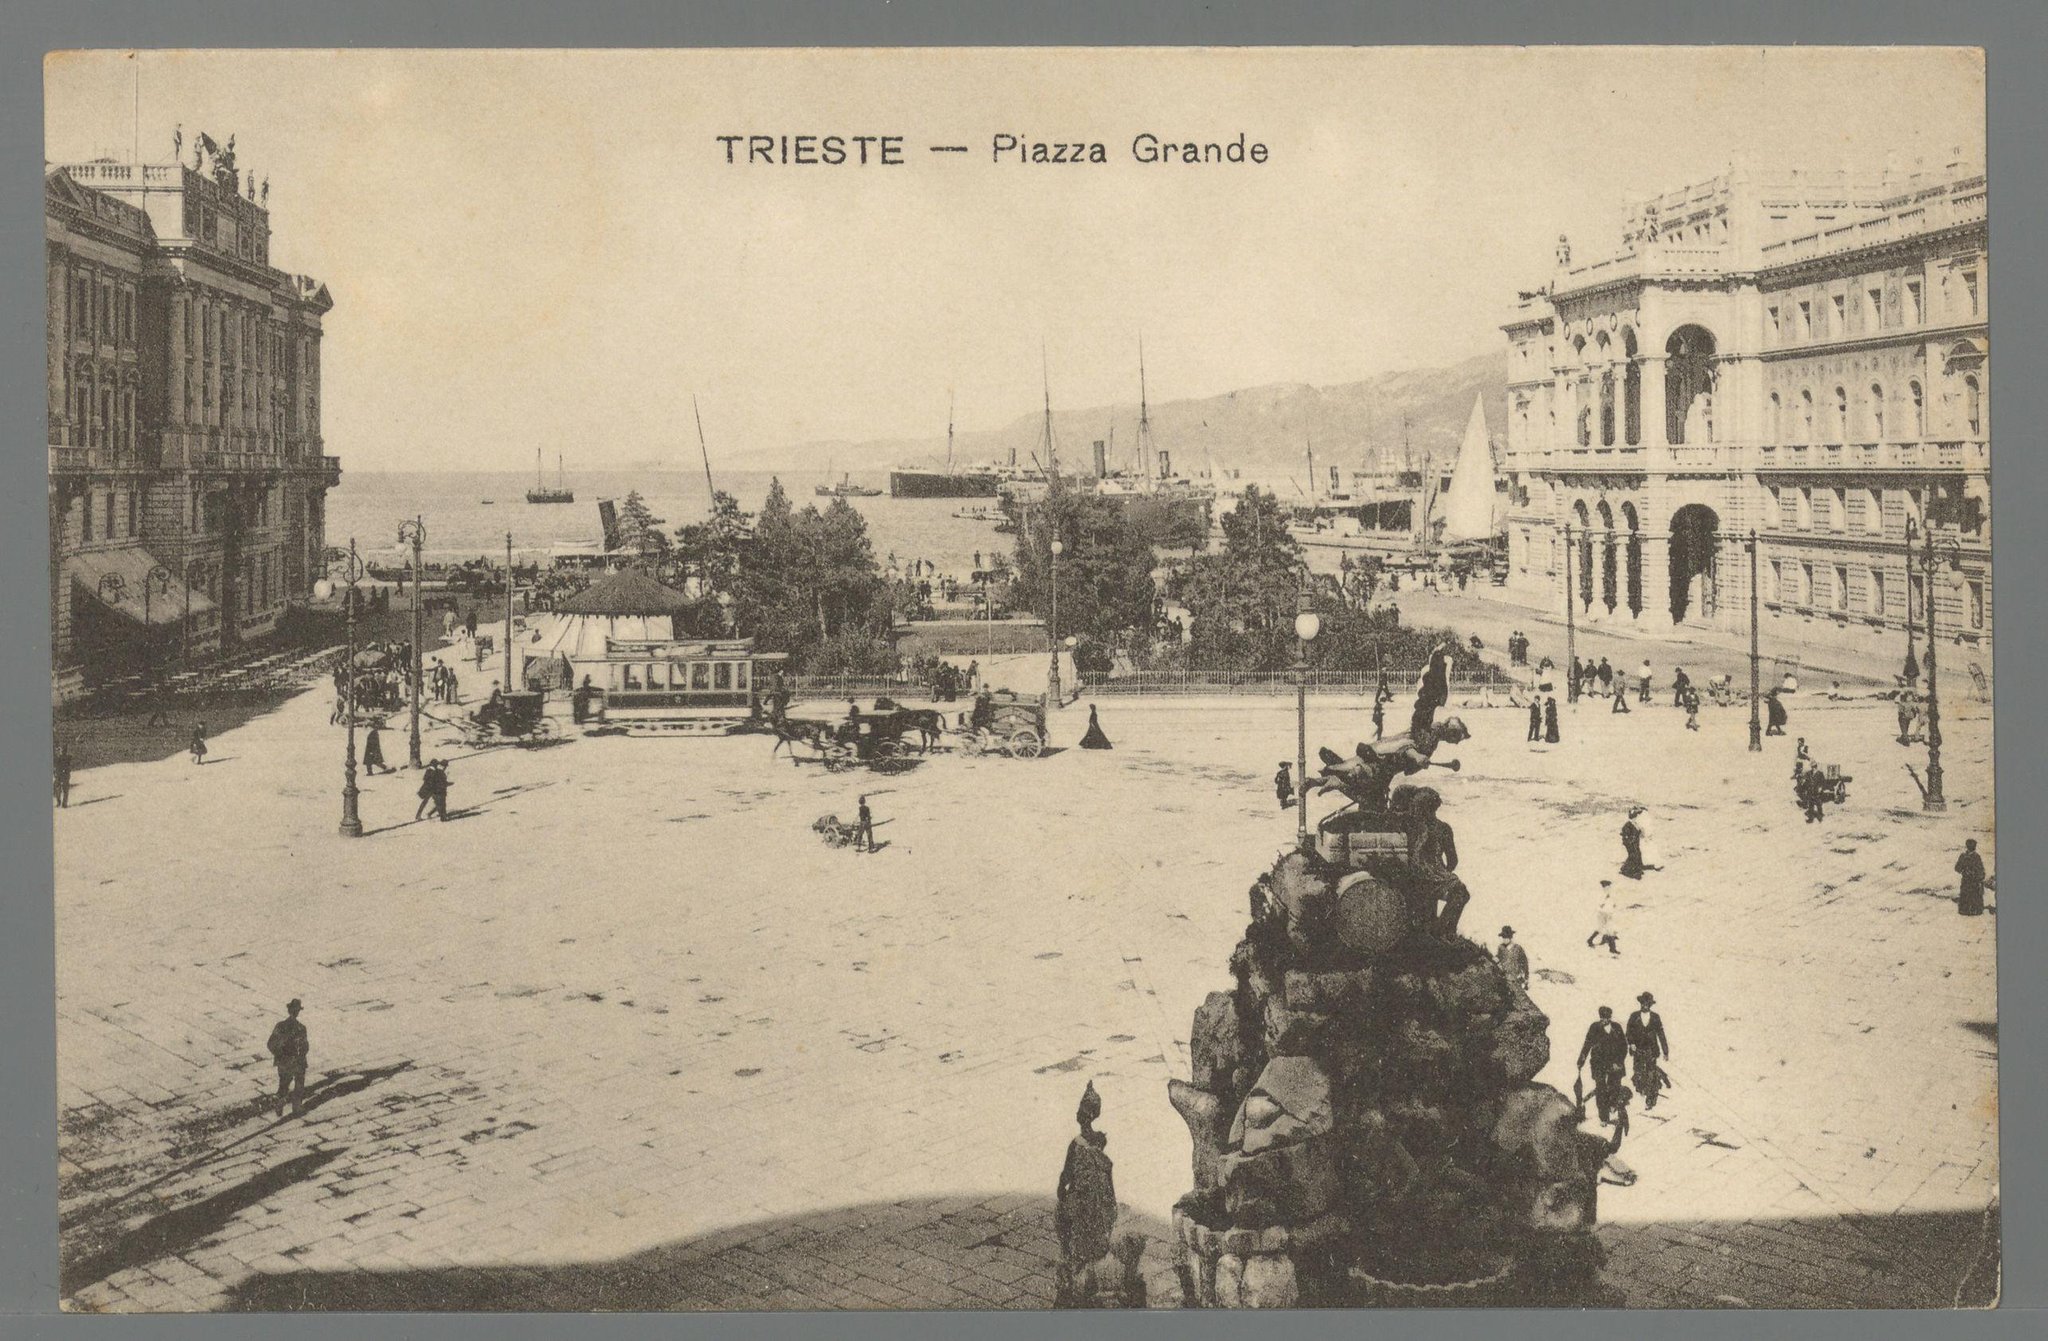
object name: photomechanical print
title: Trieste. Piazza Grande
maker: Anonymous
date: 1906-1909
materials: cardboard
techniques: photograph, writing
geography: trieste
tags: harbour, square, place, circus, etc. (+ city(-scape) with figures, staffage)